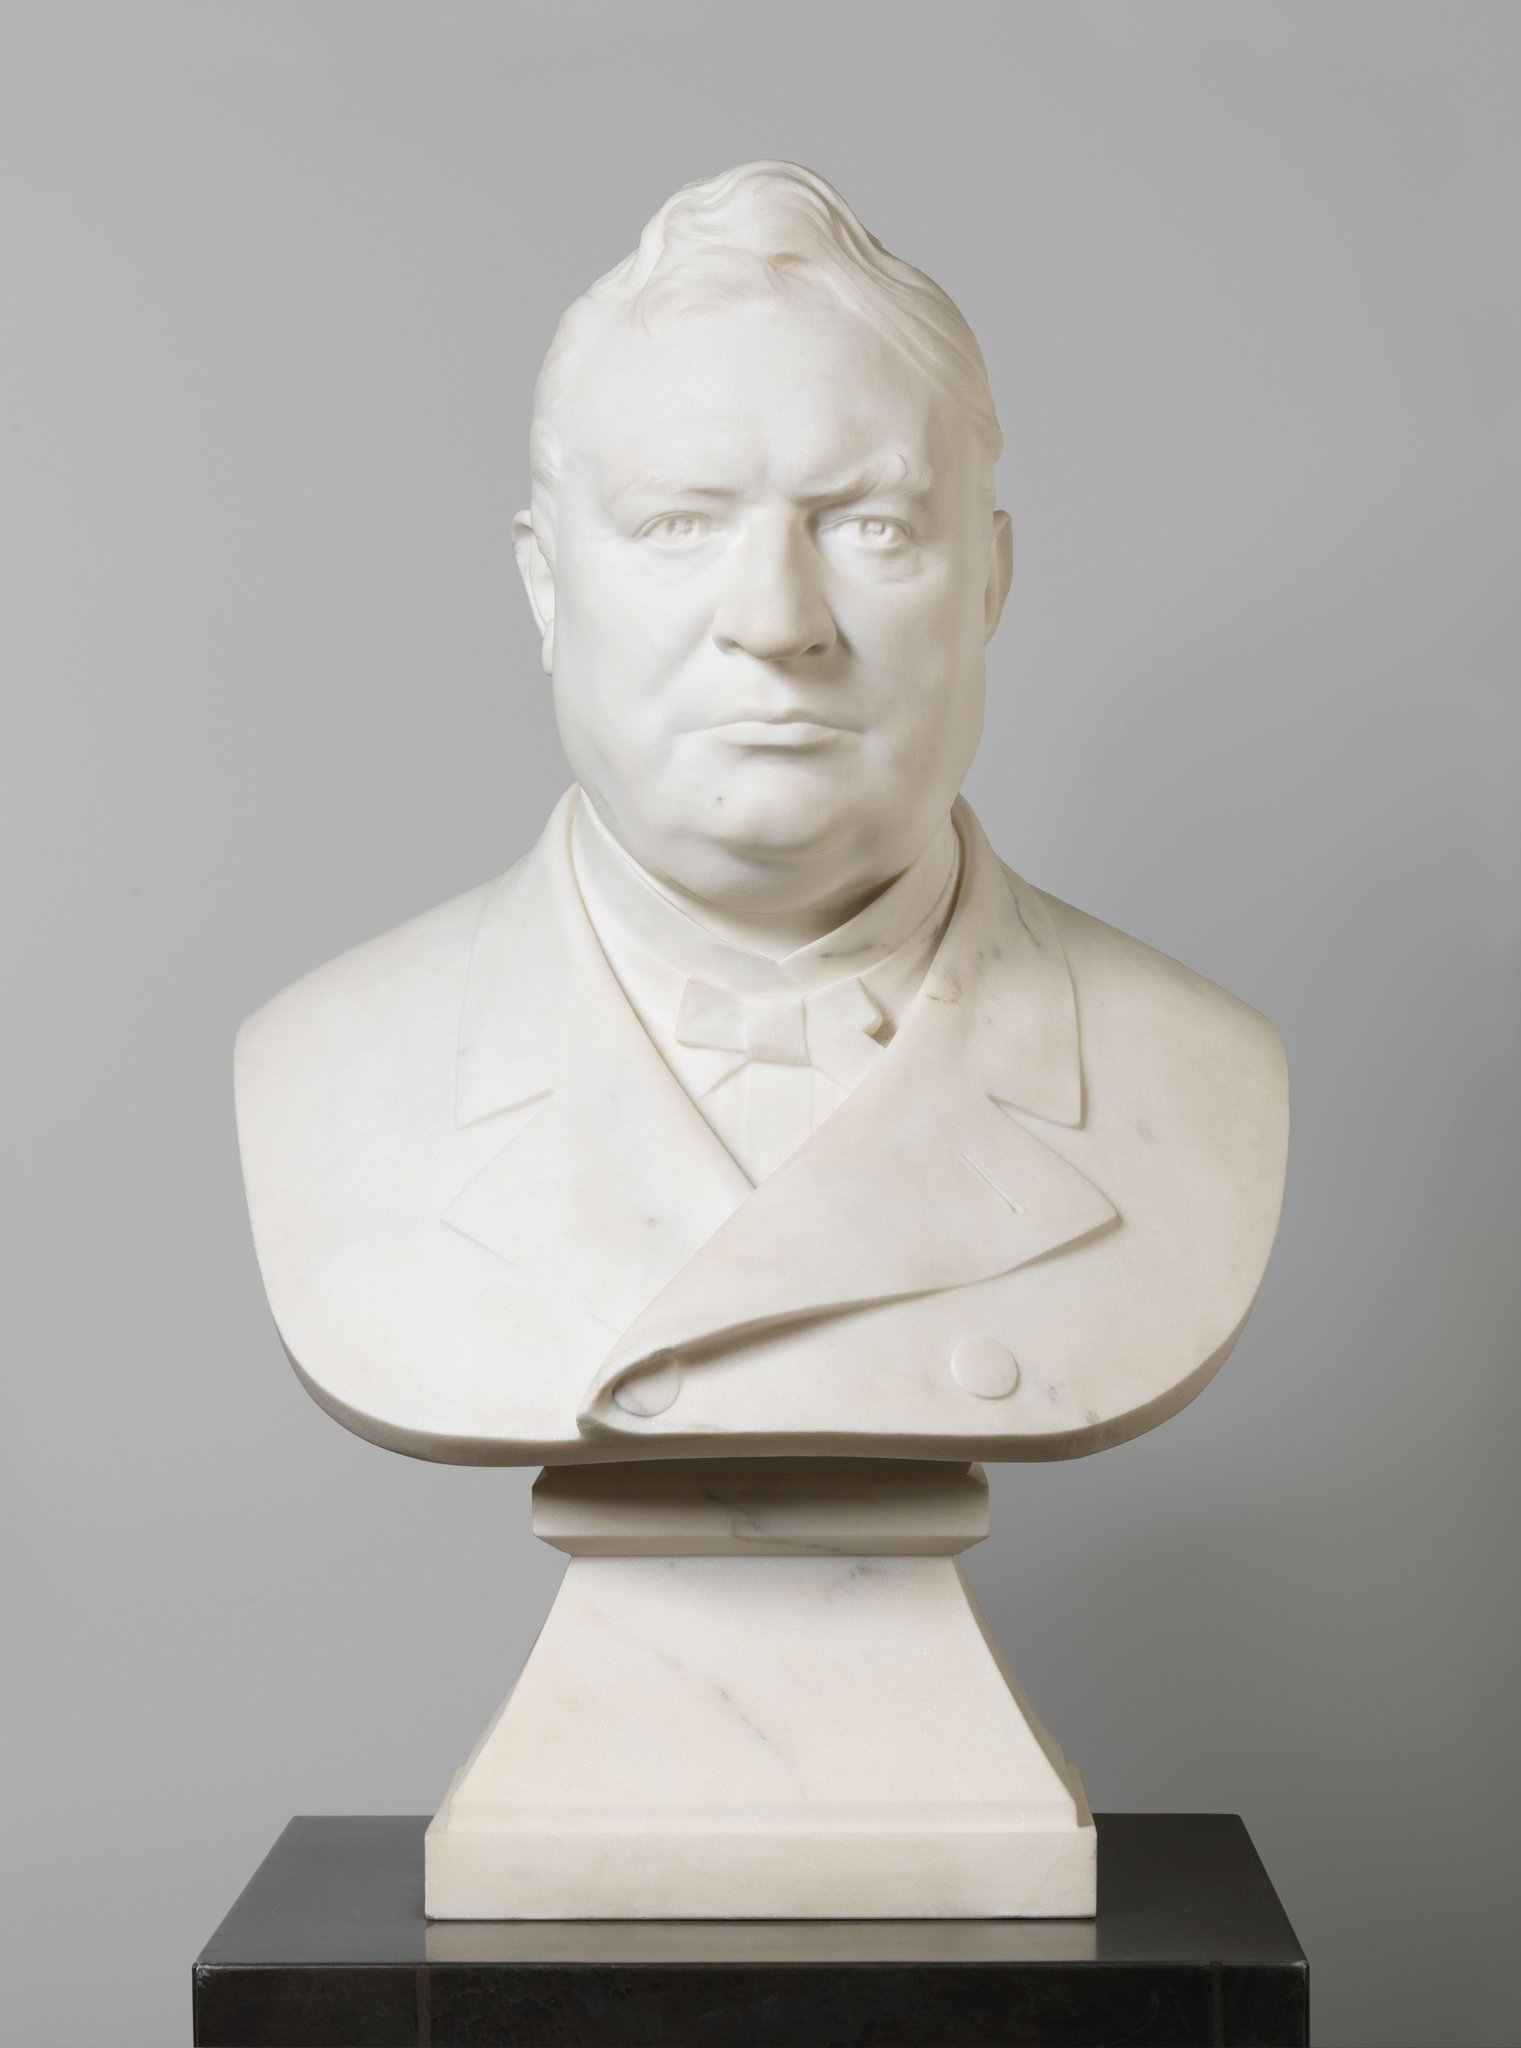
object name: sculpture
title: Borstbeeld van Hendrik Frederik Jansen (1819-1896)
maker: bart van hove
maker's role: sculptor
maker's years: 1850-1914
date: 1892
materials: marble